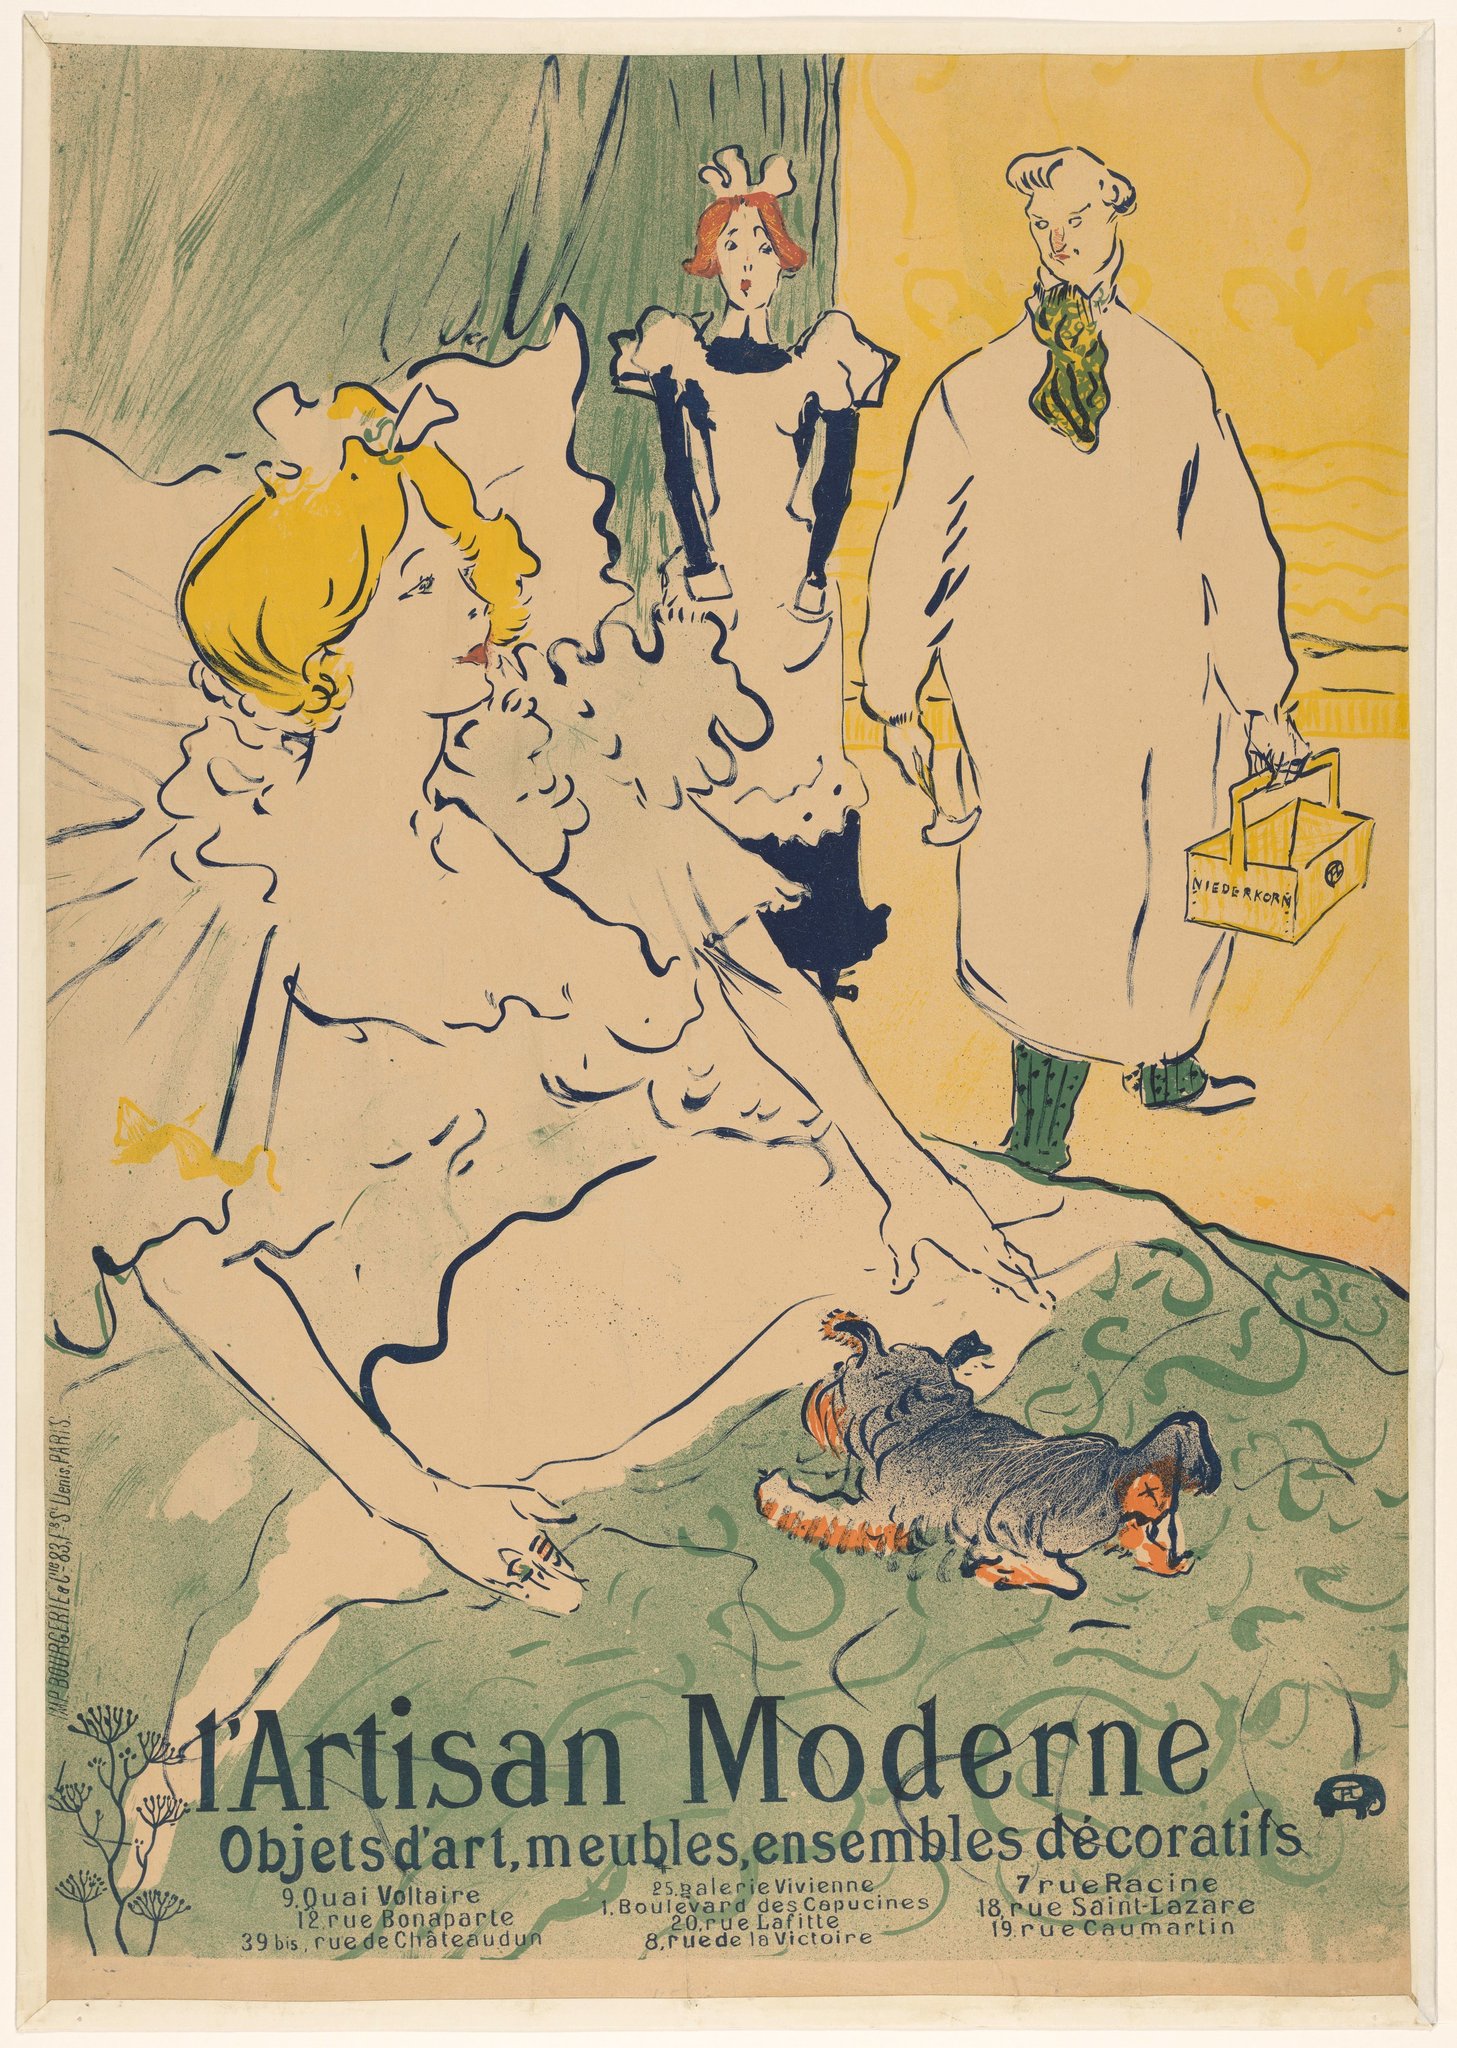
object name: print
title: L'artisan moderne. Objets d'art, meubles, ensembles décoratifs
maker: henri de toulouse-lautrec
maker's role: draughtsman, painter, print maker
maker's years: 1864-1901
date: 1896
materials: paper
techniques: lithograph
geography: paris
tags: examination, diagnosis; physician speaking with patient